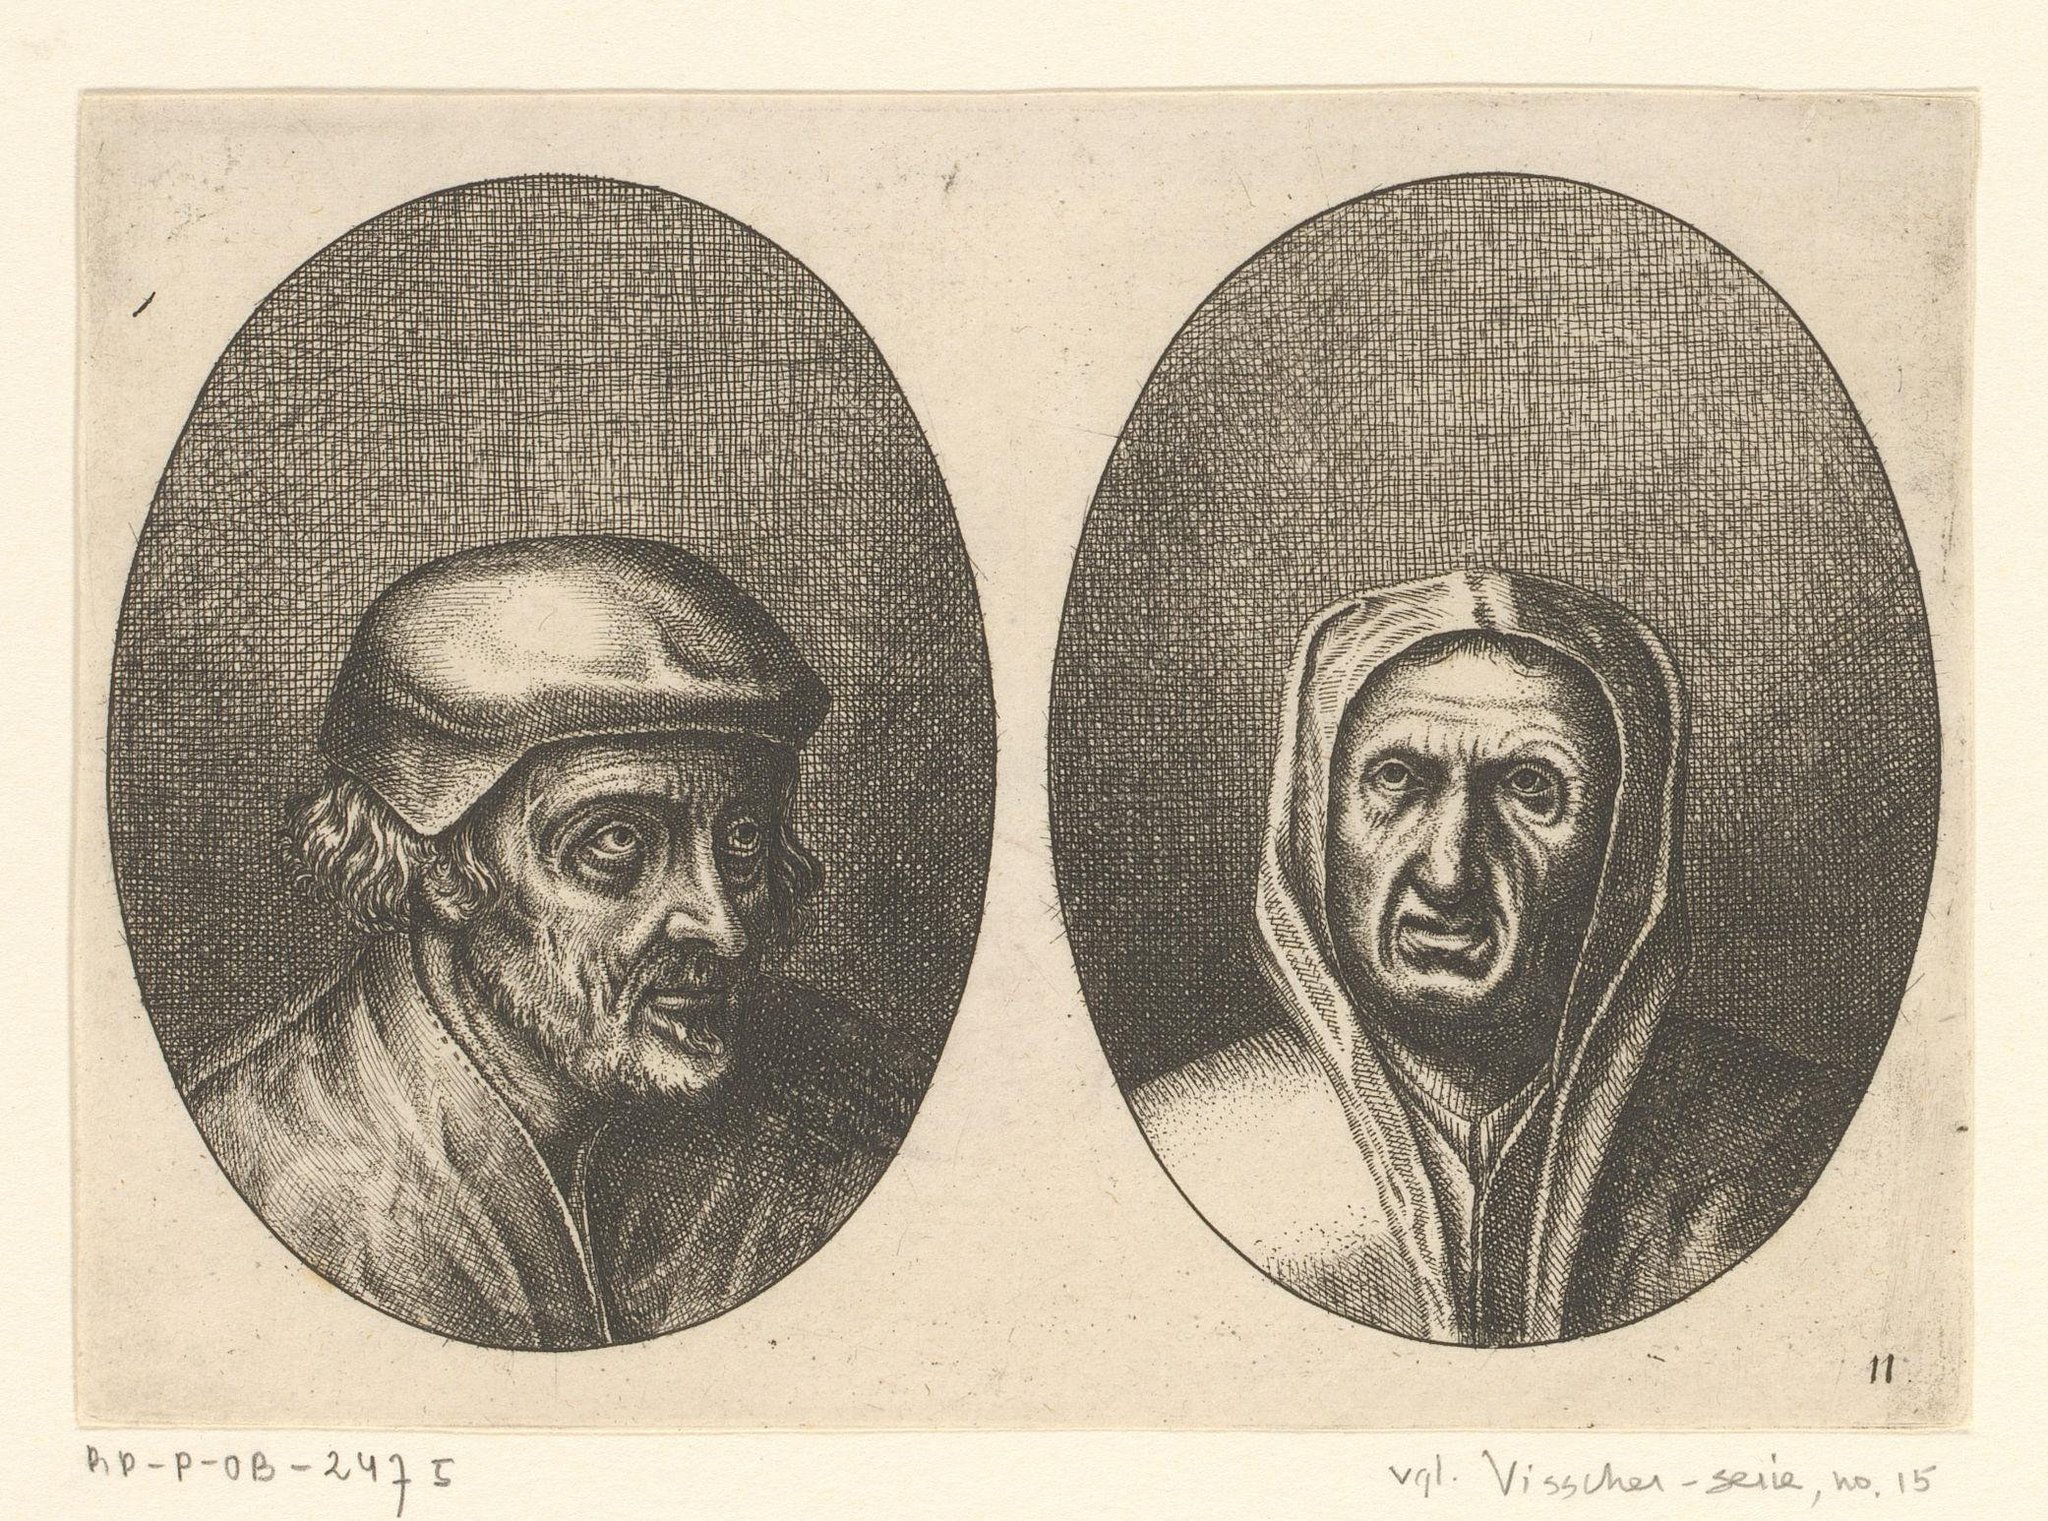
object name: print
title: Beveynsde Hil en Listighe Jorden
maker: Anonymous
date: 1612-1702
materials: paper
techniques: engraving, etching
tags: head-gear, farmers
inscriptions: collector's mark: Lugt 240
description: Vergelijk nummer 15 uit de serie 'Boerenkoppen' uitgegeven door Claes Jansz Visscher (II) tussen 1601 en 1652.